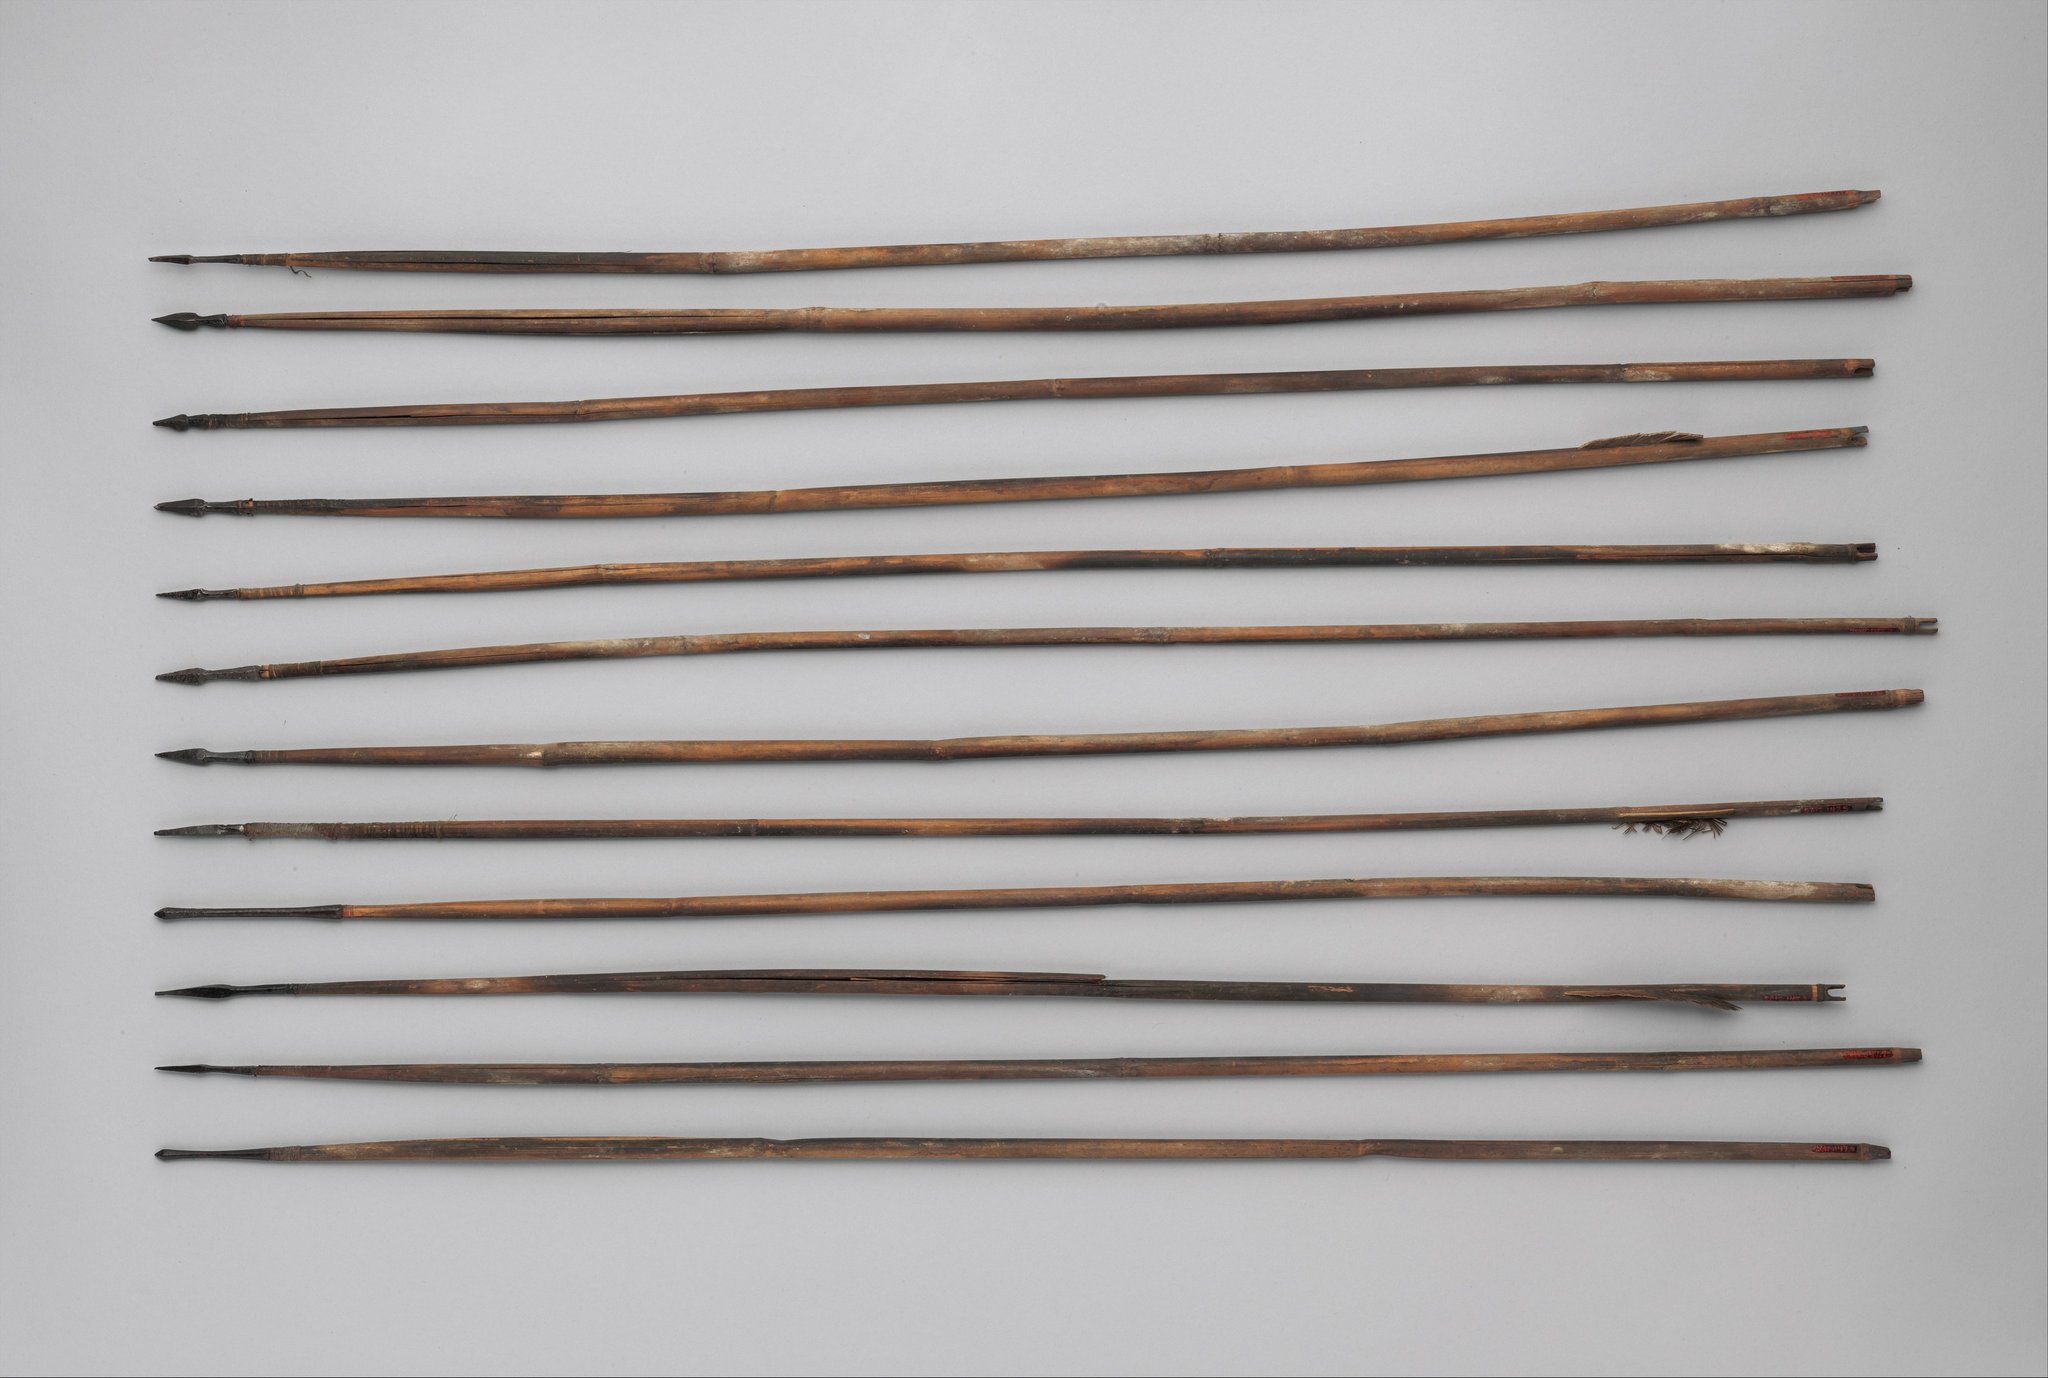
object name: twelve arrow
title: Twelve Arrows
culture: tibetan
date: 1501-1800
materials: feather, iron, wood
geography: tibet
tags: arrows